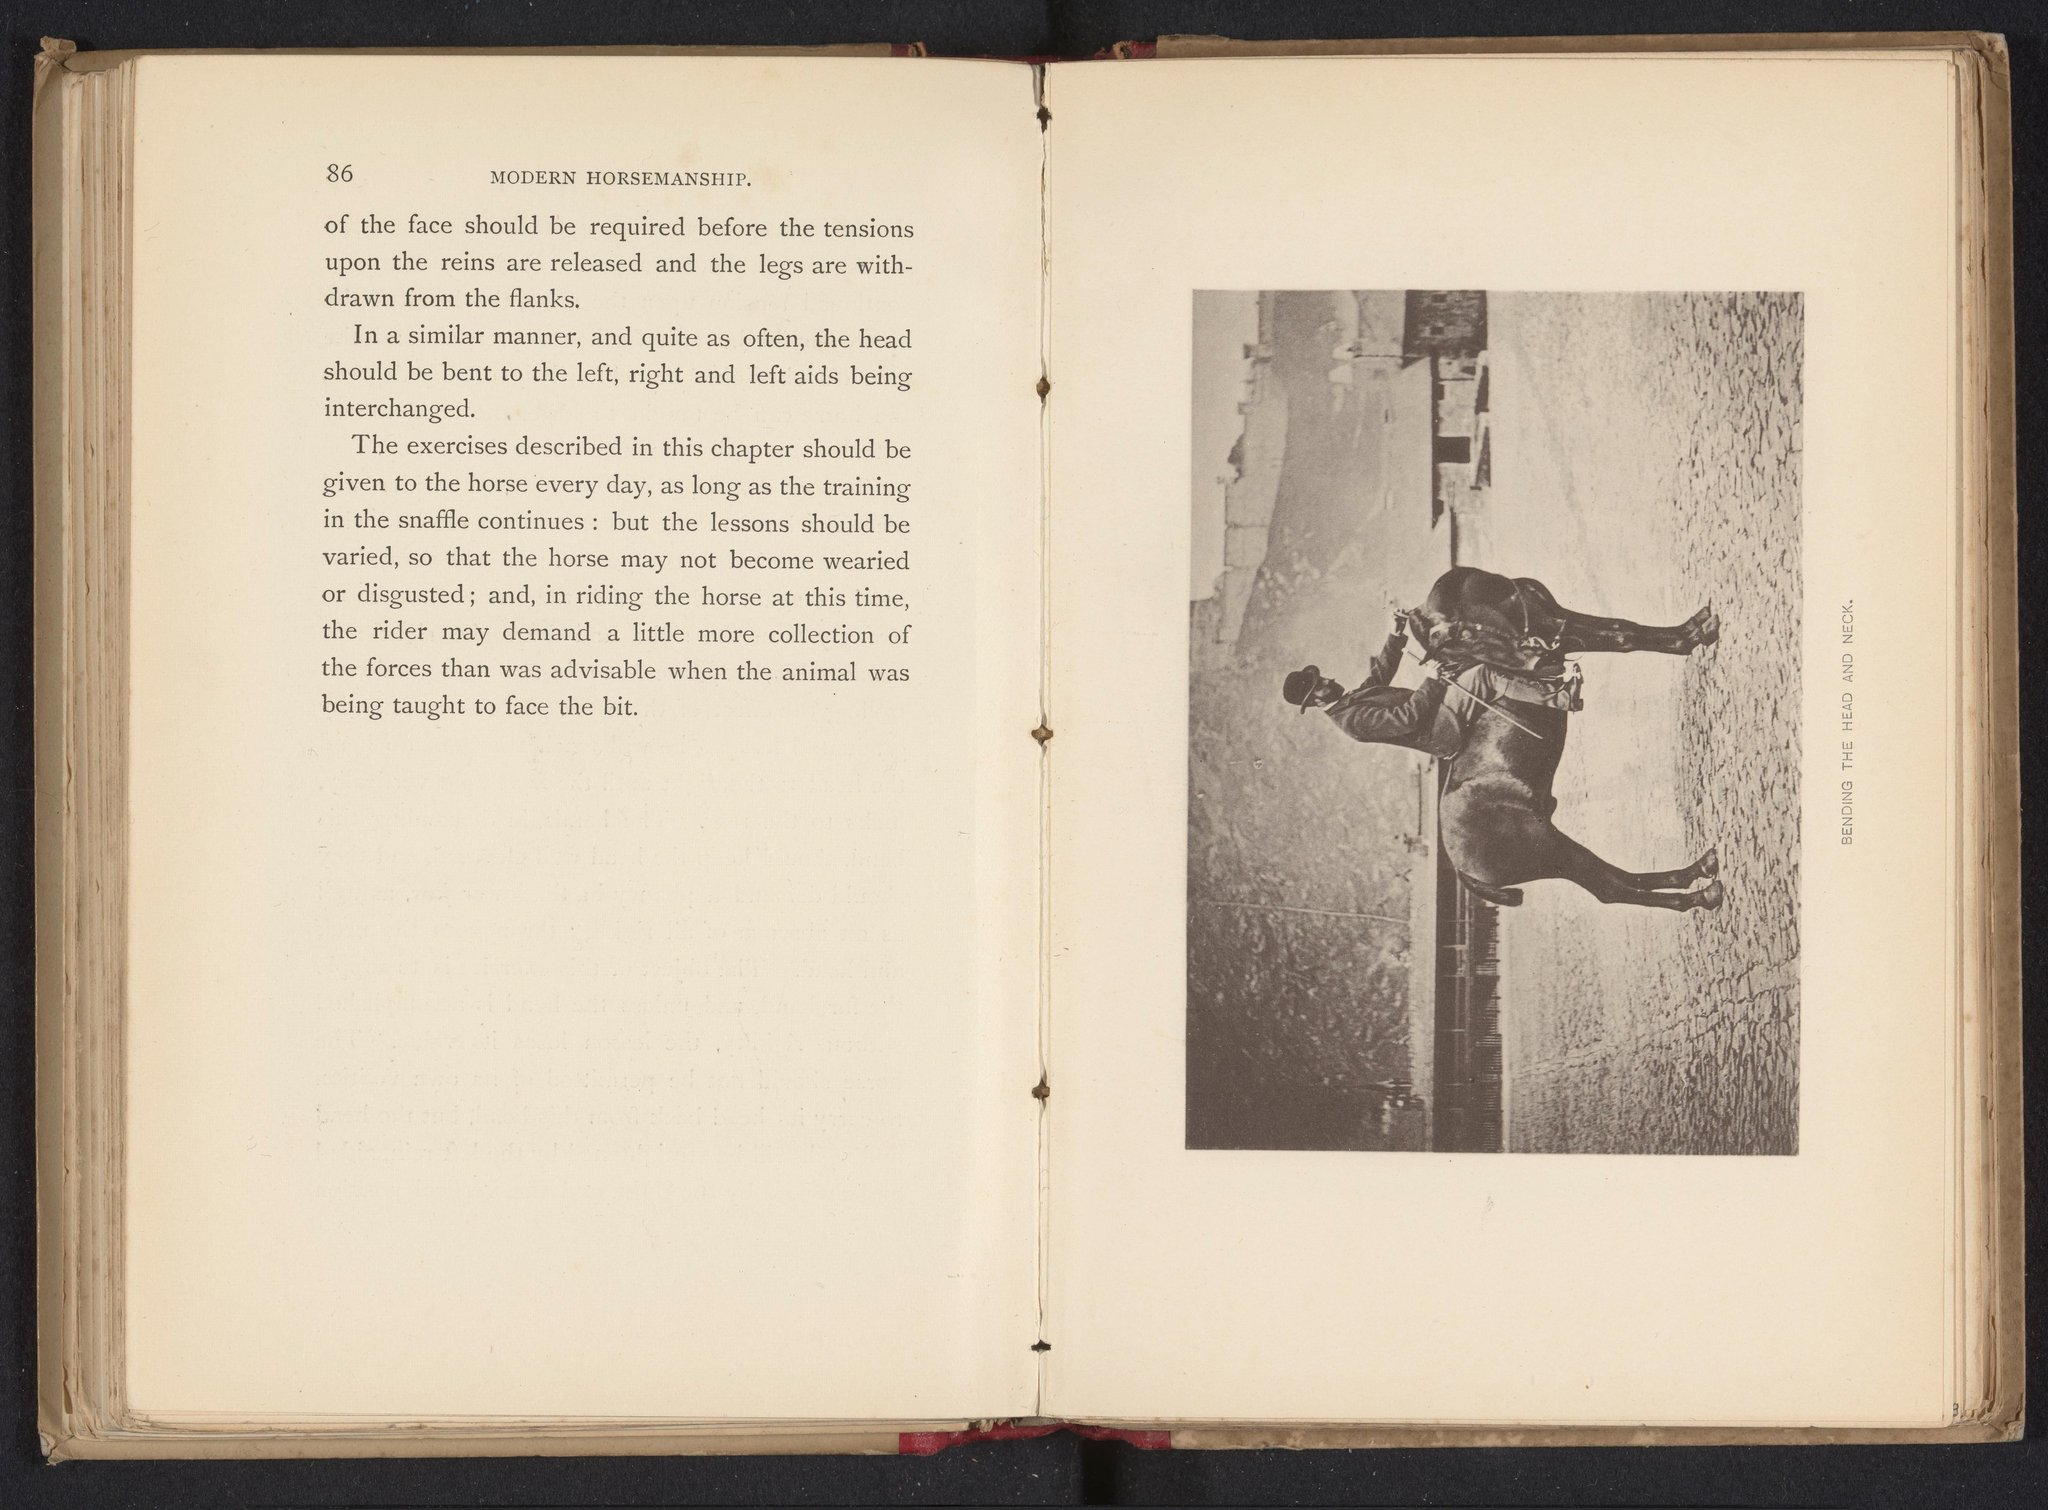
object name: page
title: Bending the head and neck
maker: alexander nicol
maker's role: fotograaf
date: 1879-1889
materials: paper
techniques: photograph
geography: edinburgh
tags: riding a horse, ass, or mule; rider, horseman, head-gear: bowler hat, horse